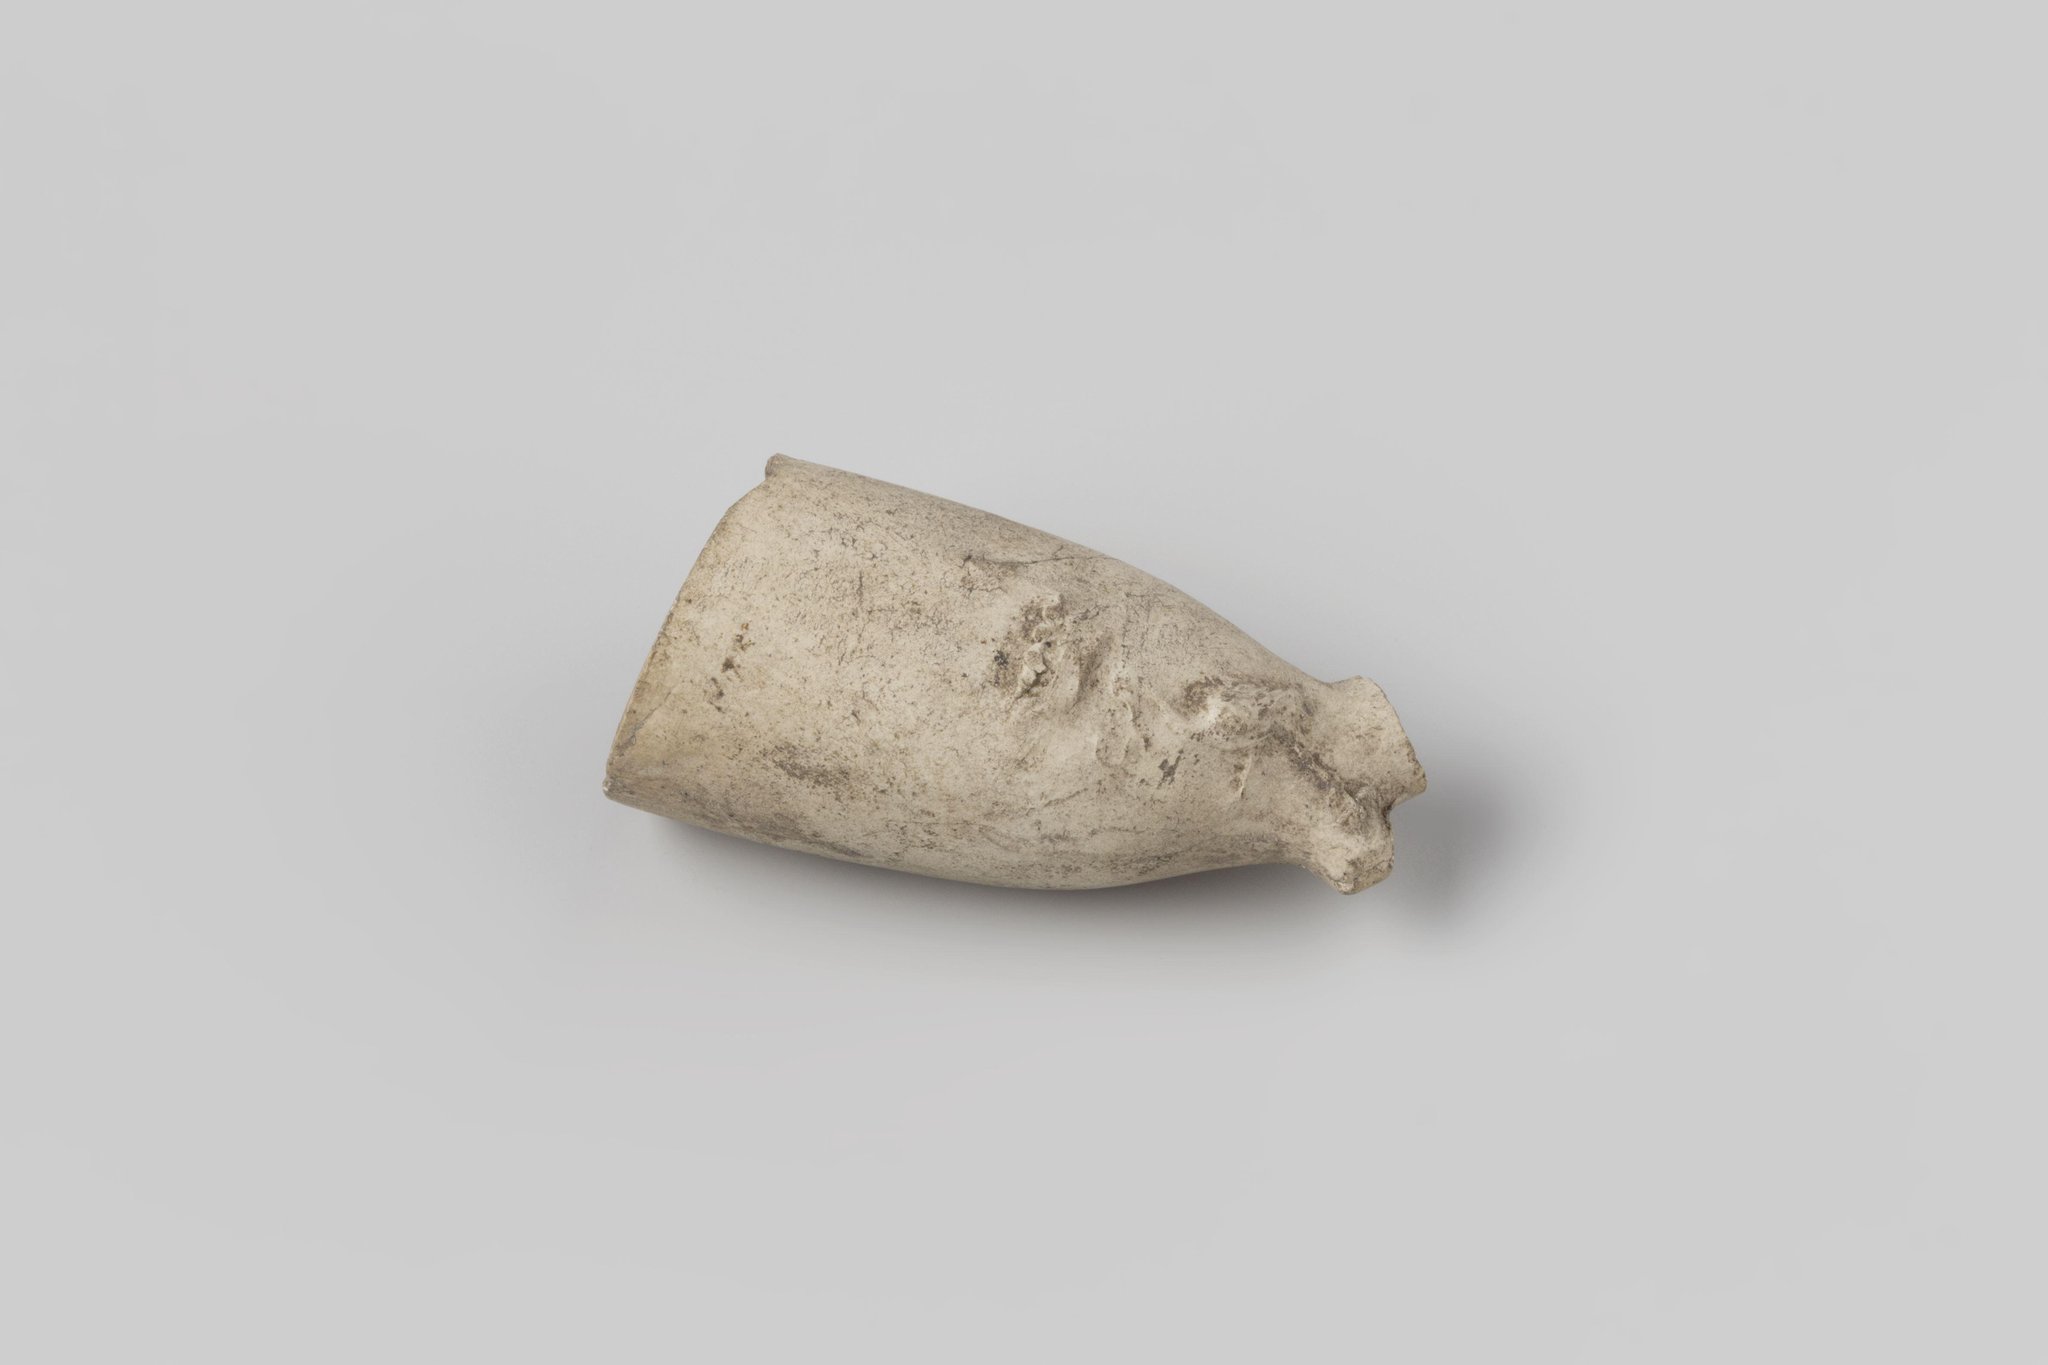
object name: pipe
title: Fragment pijpenkop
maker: Anonymous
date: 1710-1740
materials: clay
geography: netherlands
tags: the hague, shore-birds and wading-birds: stork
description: Fragment pijpenkop met een kroon en een ooievaar met paling in de bek afgebeeld. Van de opgravingen op de Hofstede Arentsburg 1827-1831 onder toezicht van Professor Reuvens.